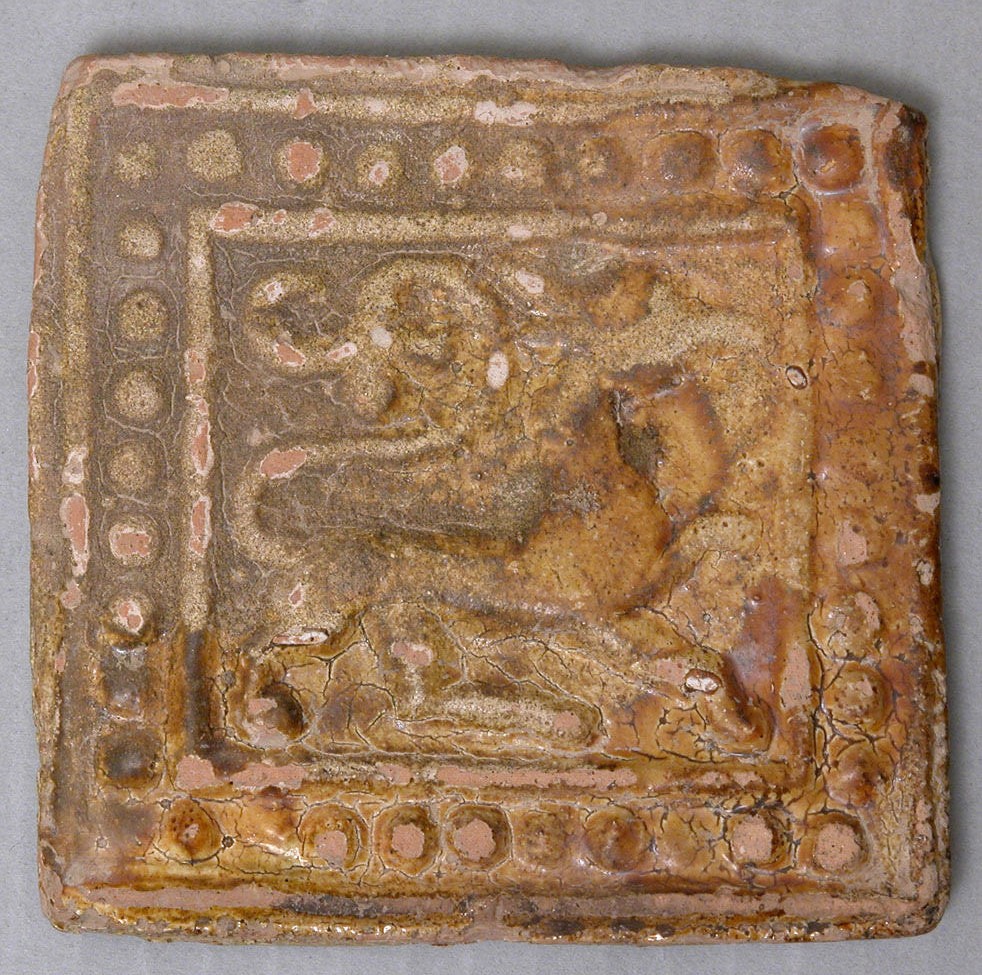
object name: tile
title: Square Tile Showing a Lion with Foliated Tail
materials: earthenware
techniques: glazing, molding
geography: afghanistan